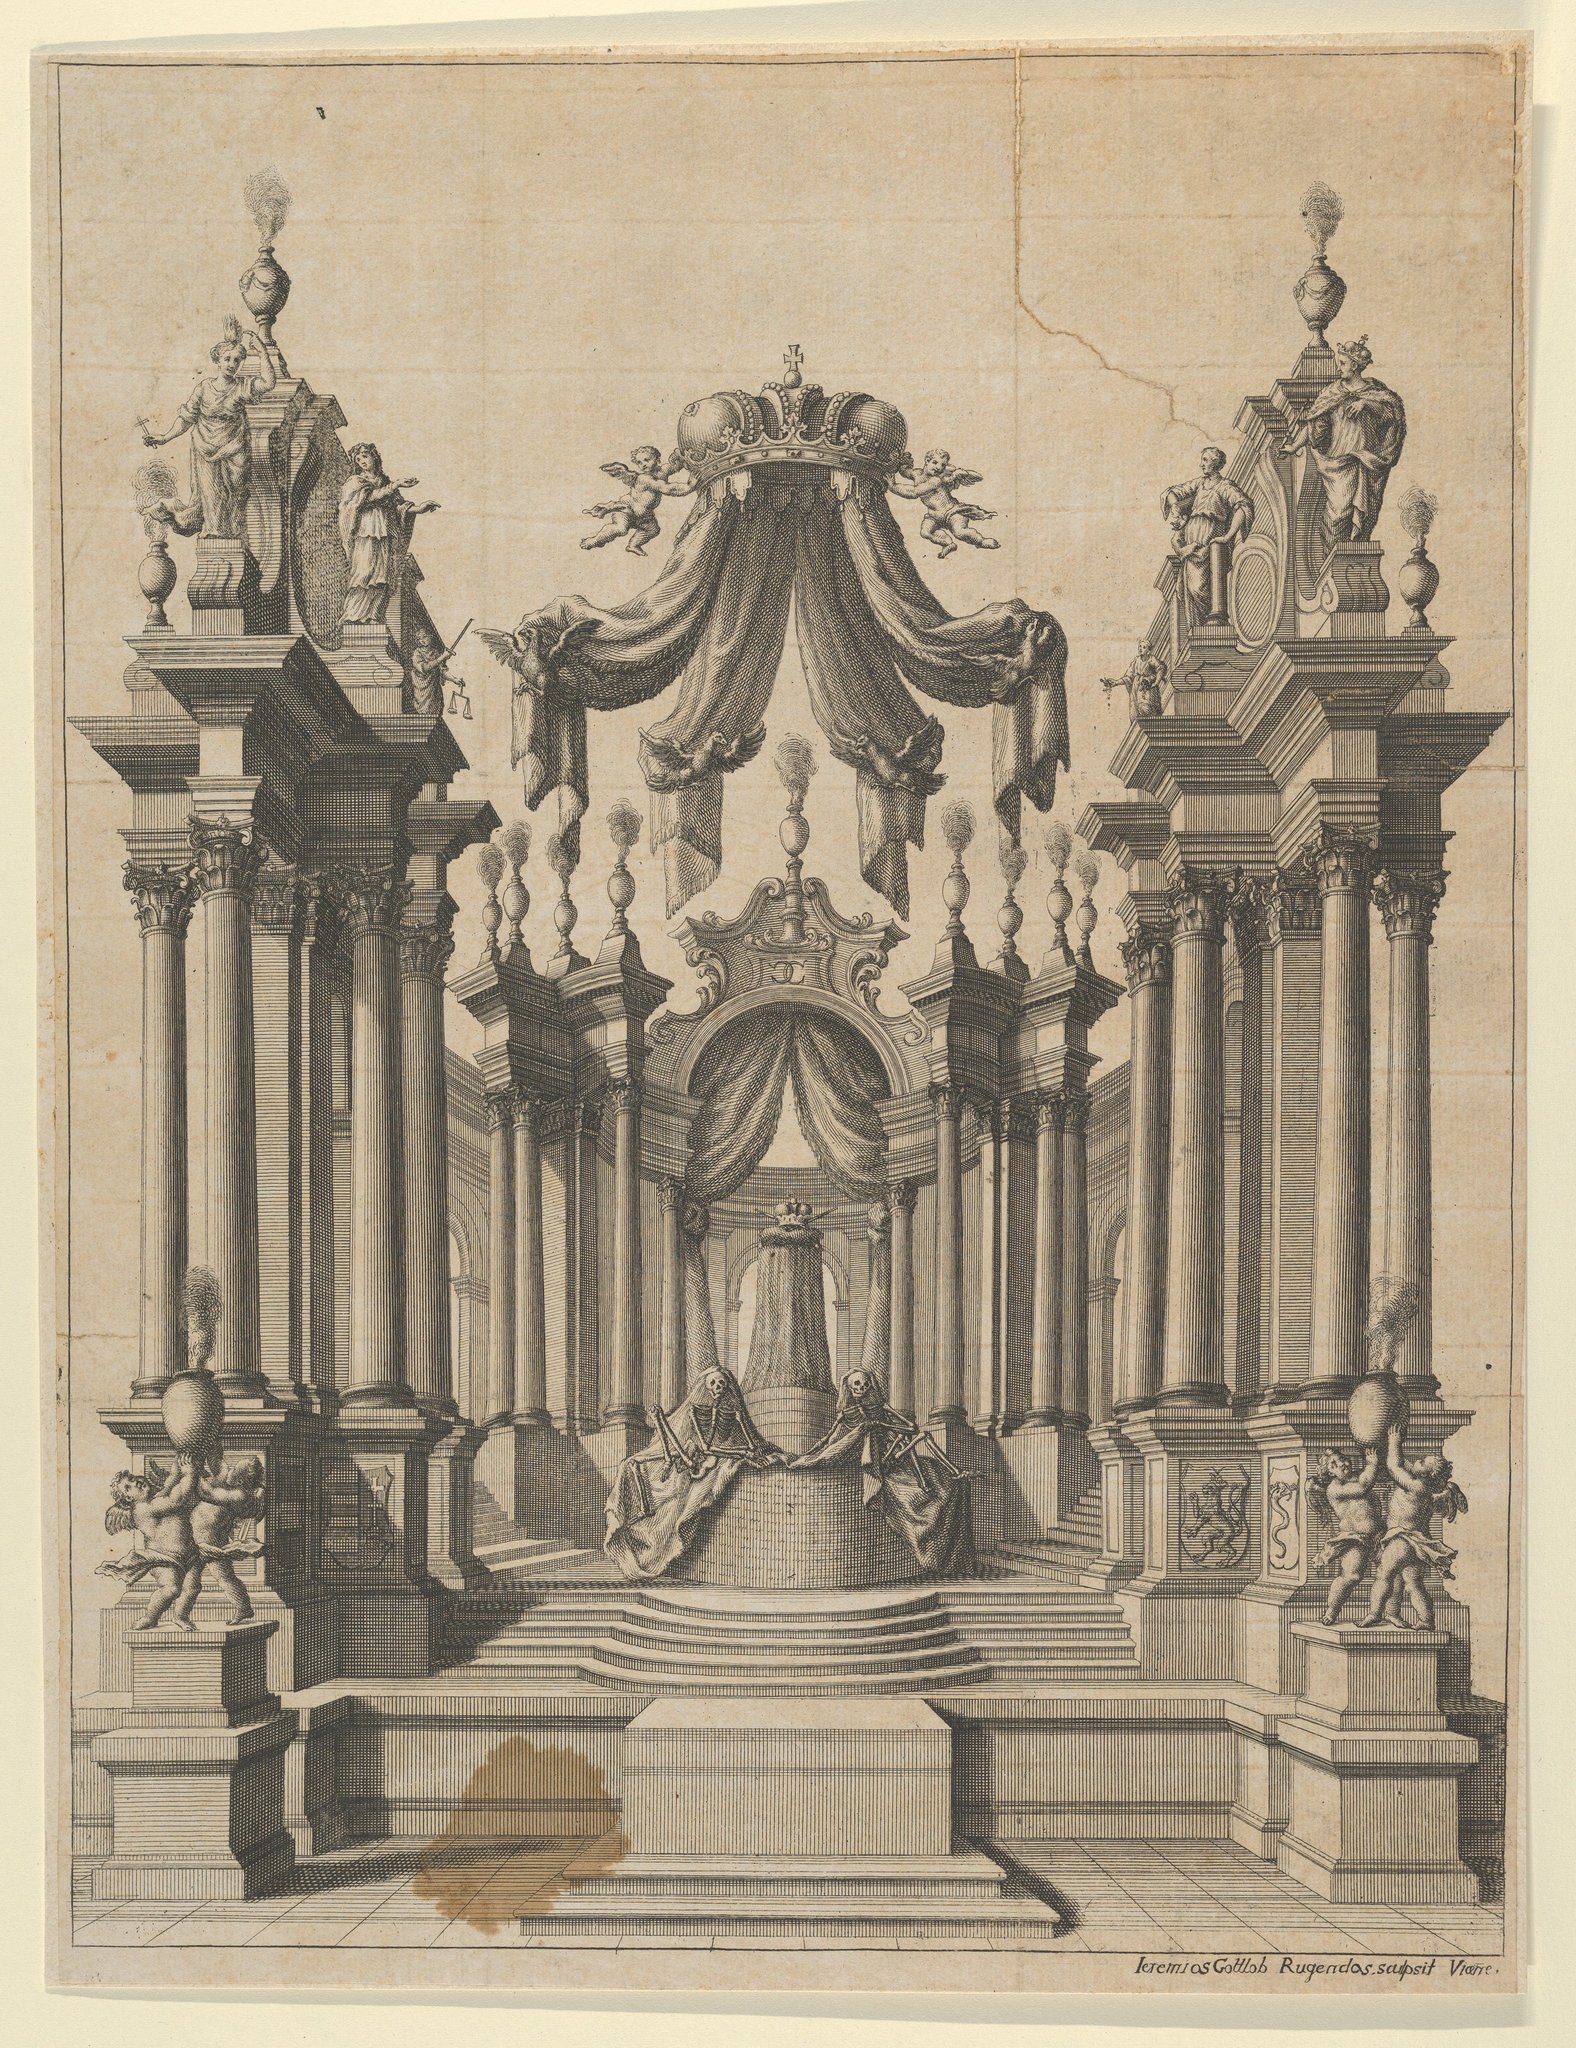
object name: print, fete, ornament architecture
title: Catafalque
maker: jeremias gottlob rugendas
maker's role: artist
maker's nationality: german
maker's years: 1711-1772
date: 1701-1800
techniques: engraving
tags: architecture,columns